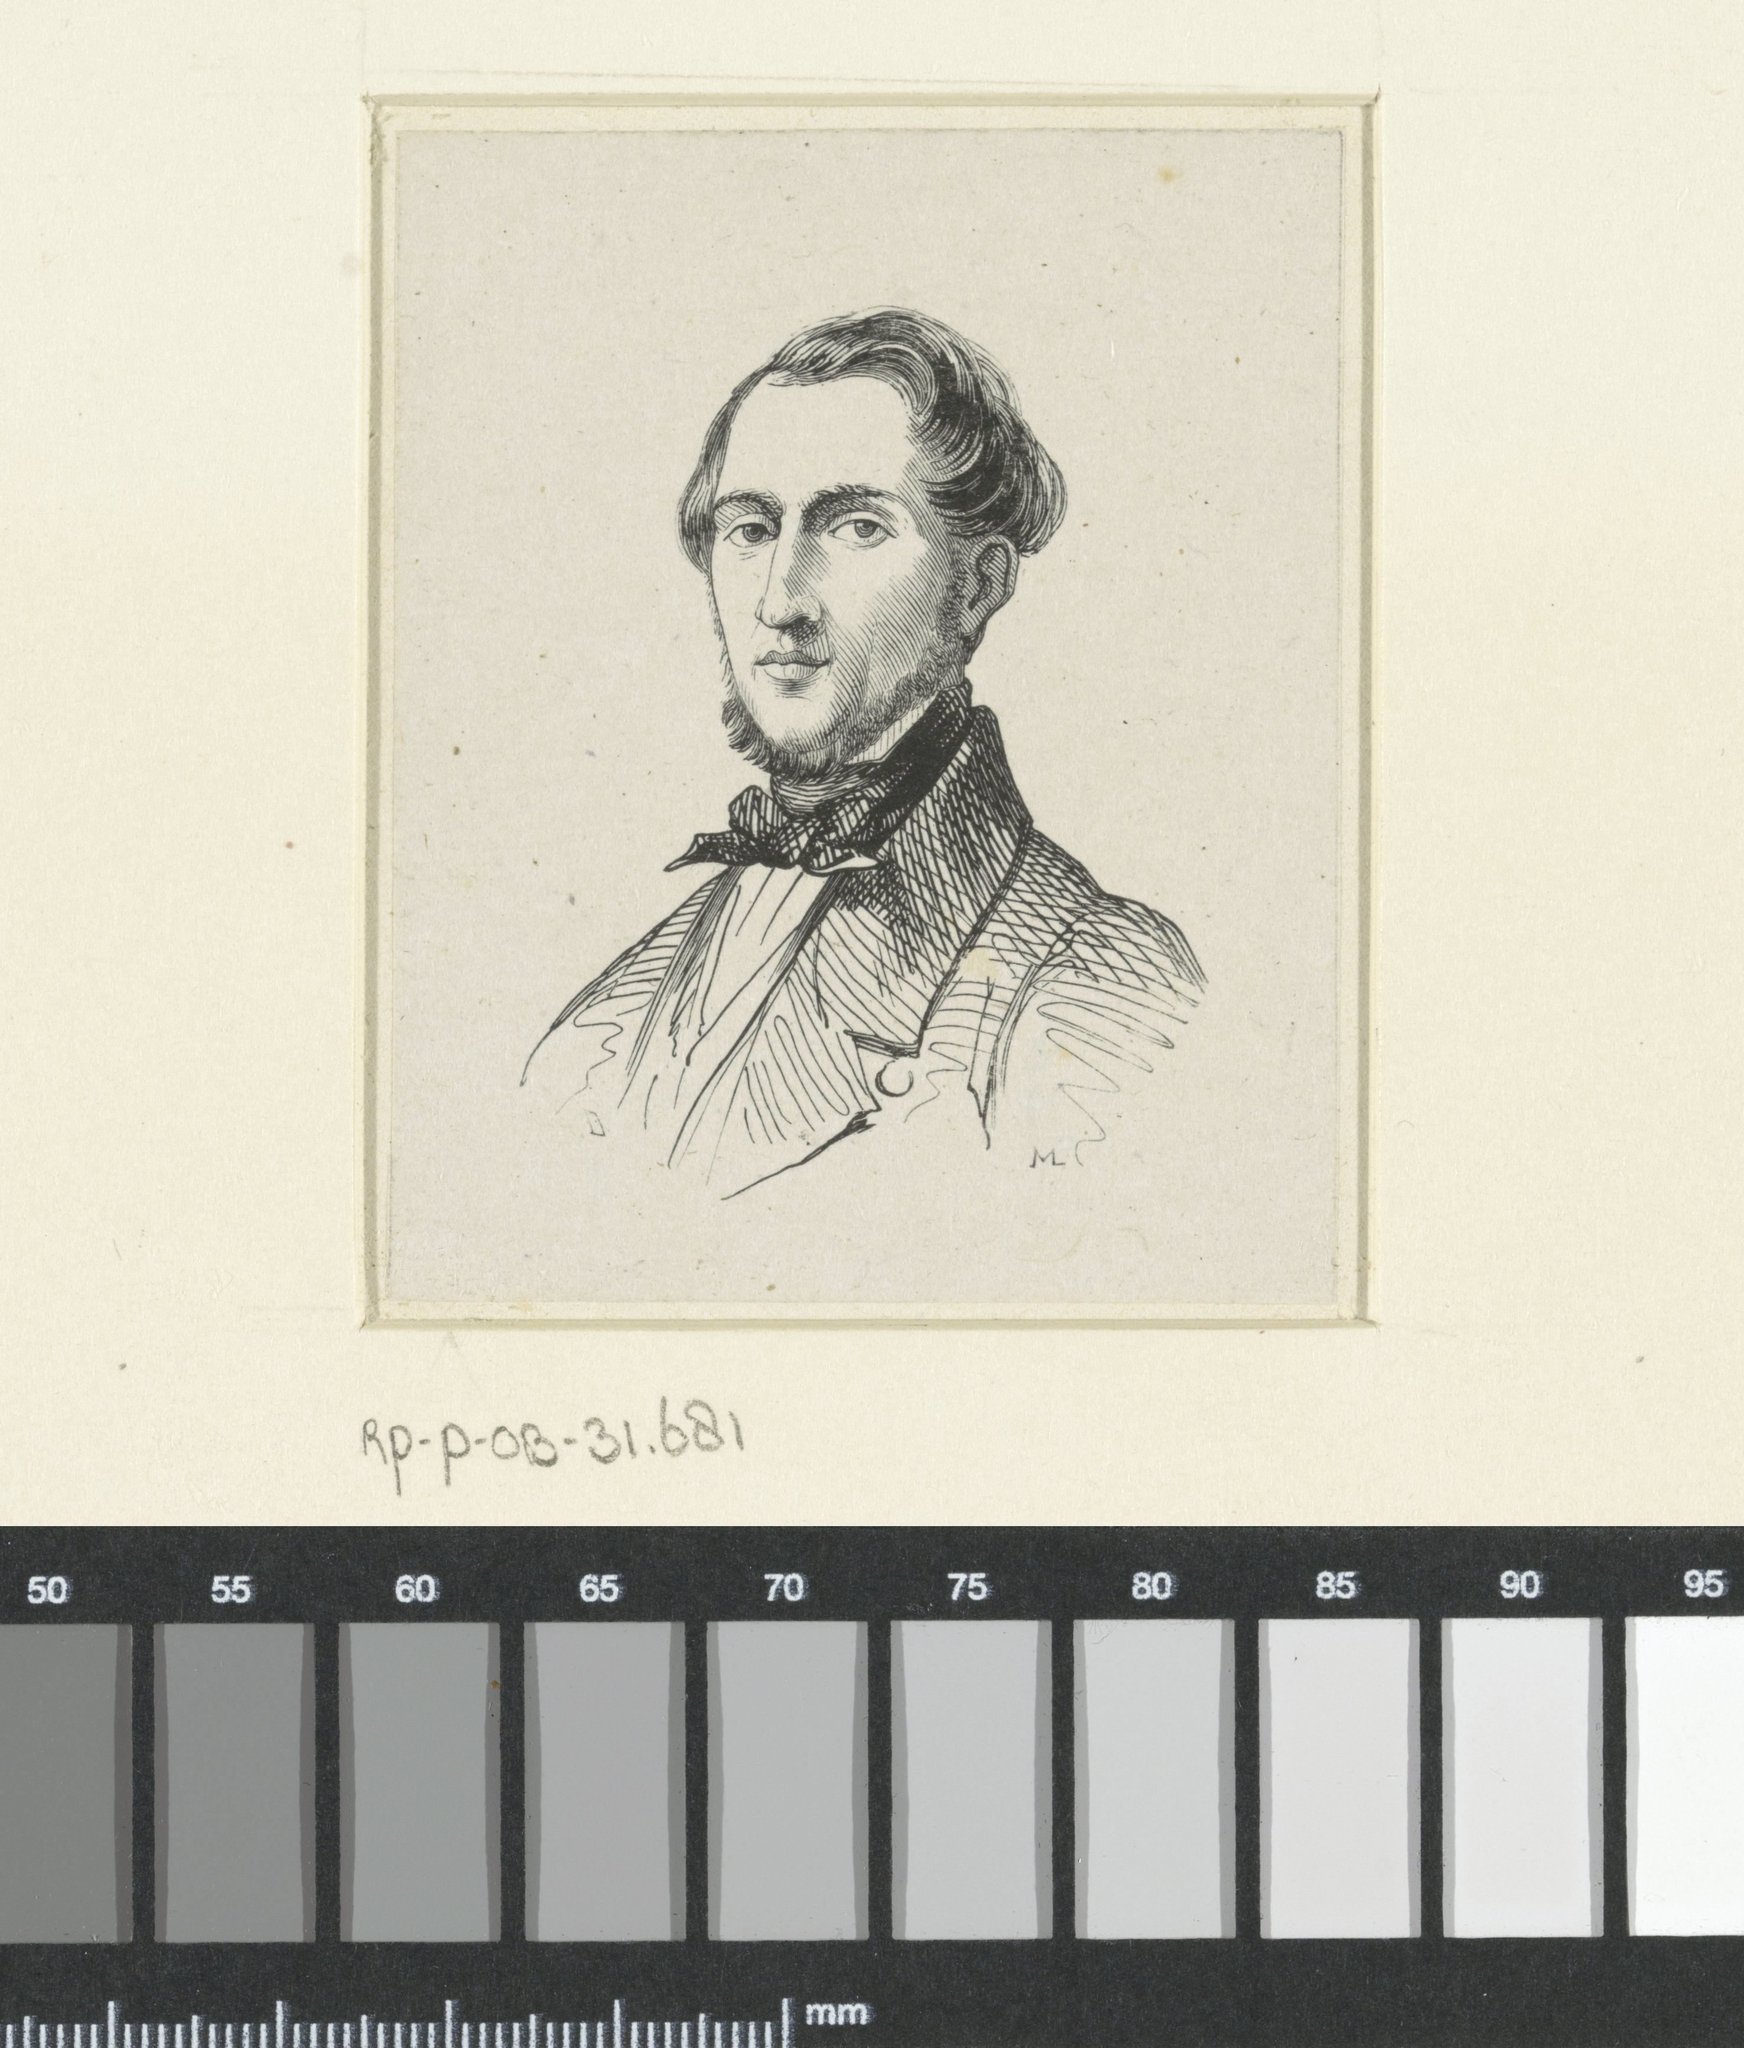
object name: print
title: Portret van Reinier Craeyvanger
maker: monogrammist m (duitsland)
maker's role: print maker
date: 1841-1842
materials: paper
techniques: engraving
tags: amsterdam, print maker, reinier craeyvanger, historical persons, portrait, self-portrait of painter, portrait, self-portrait of artist, portrait, self-portrait of draughtsman